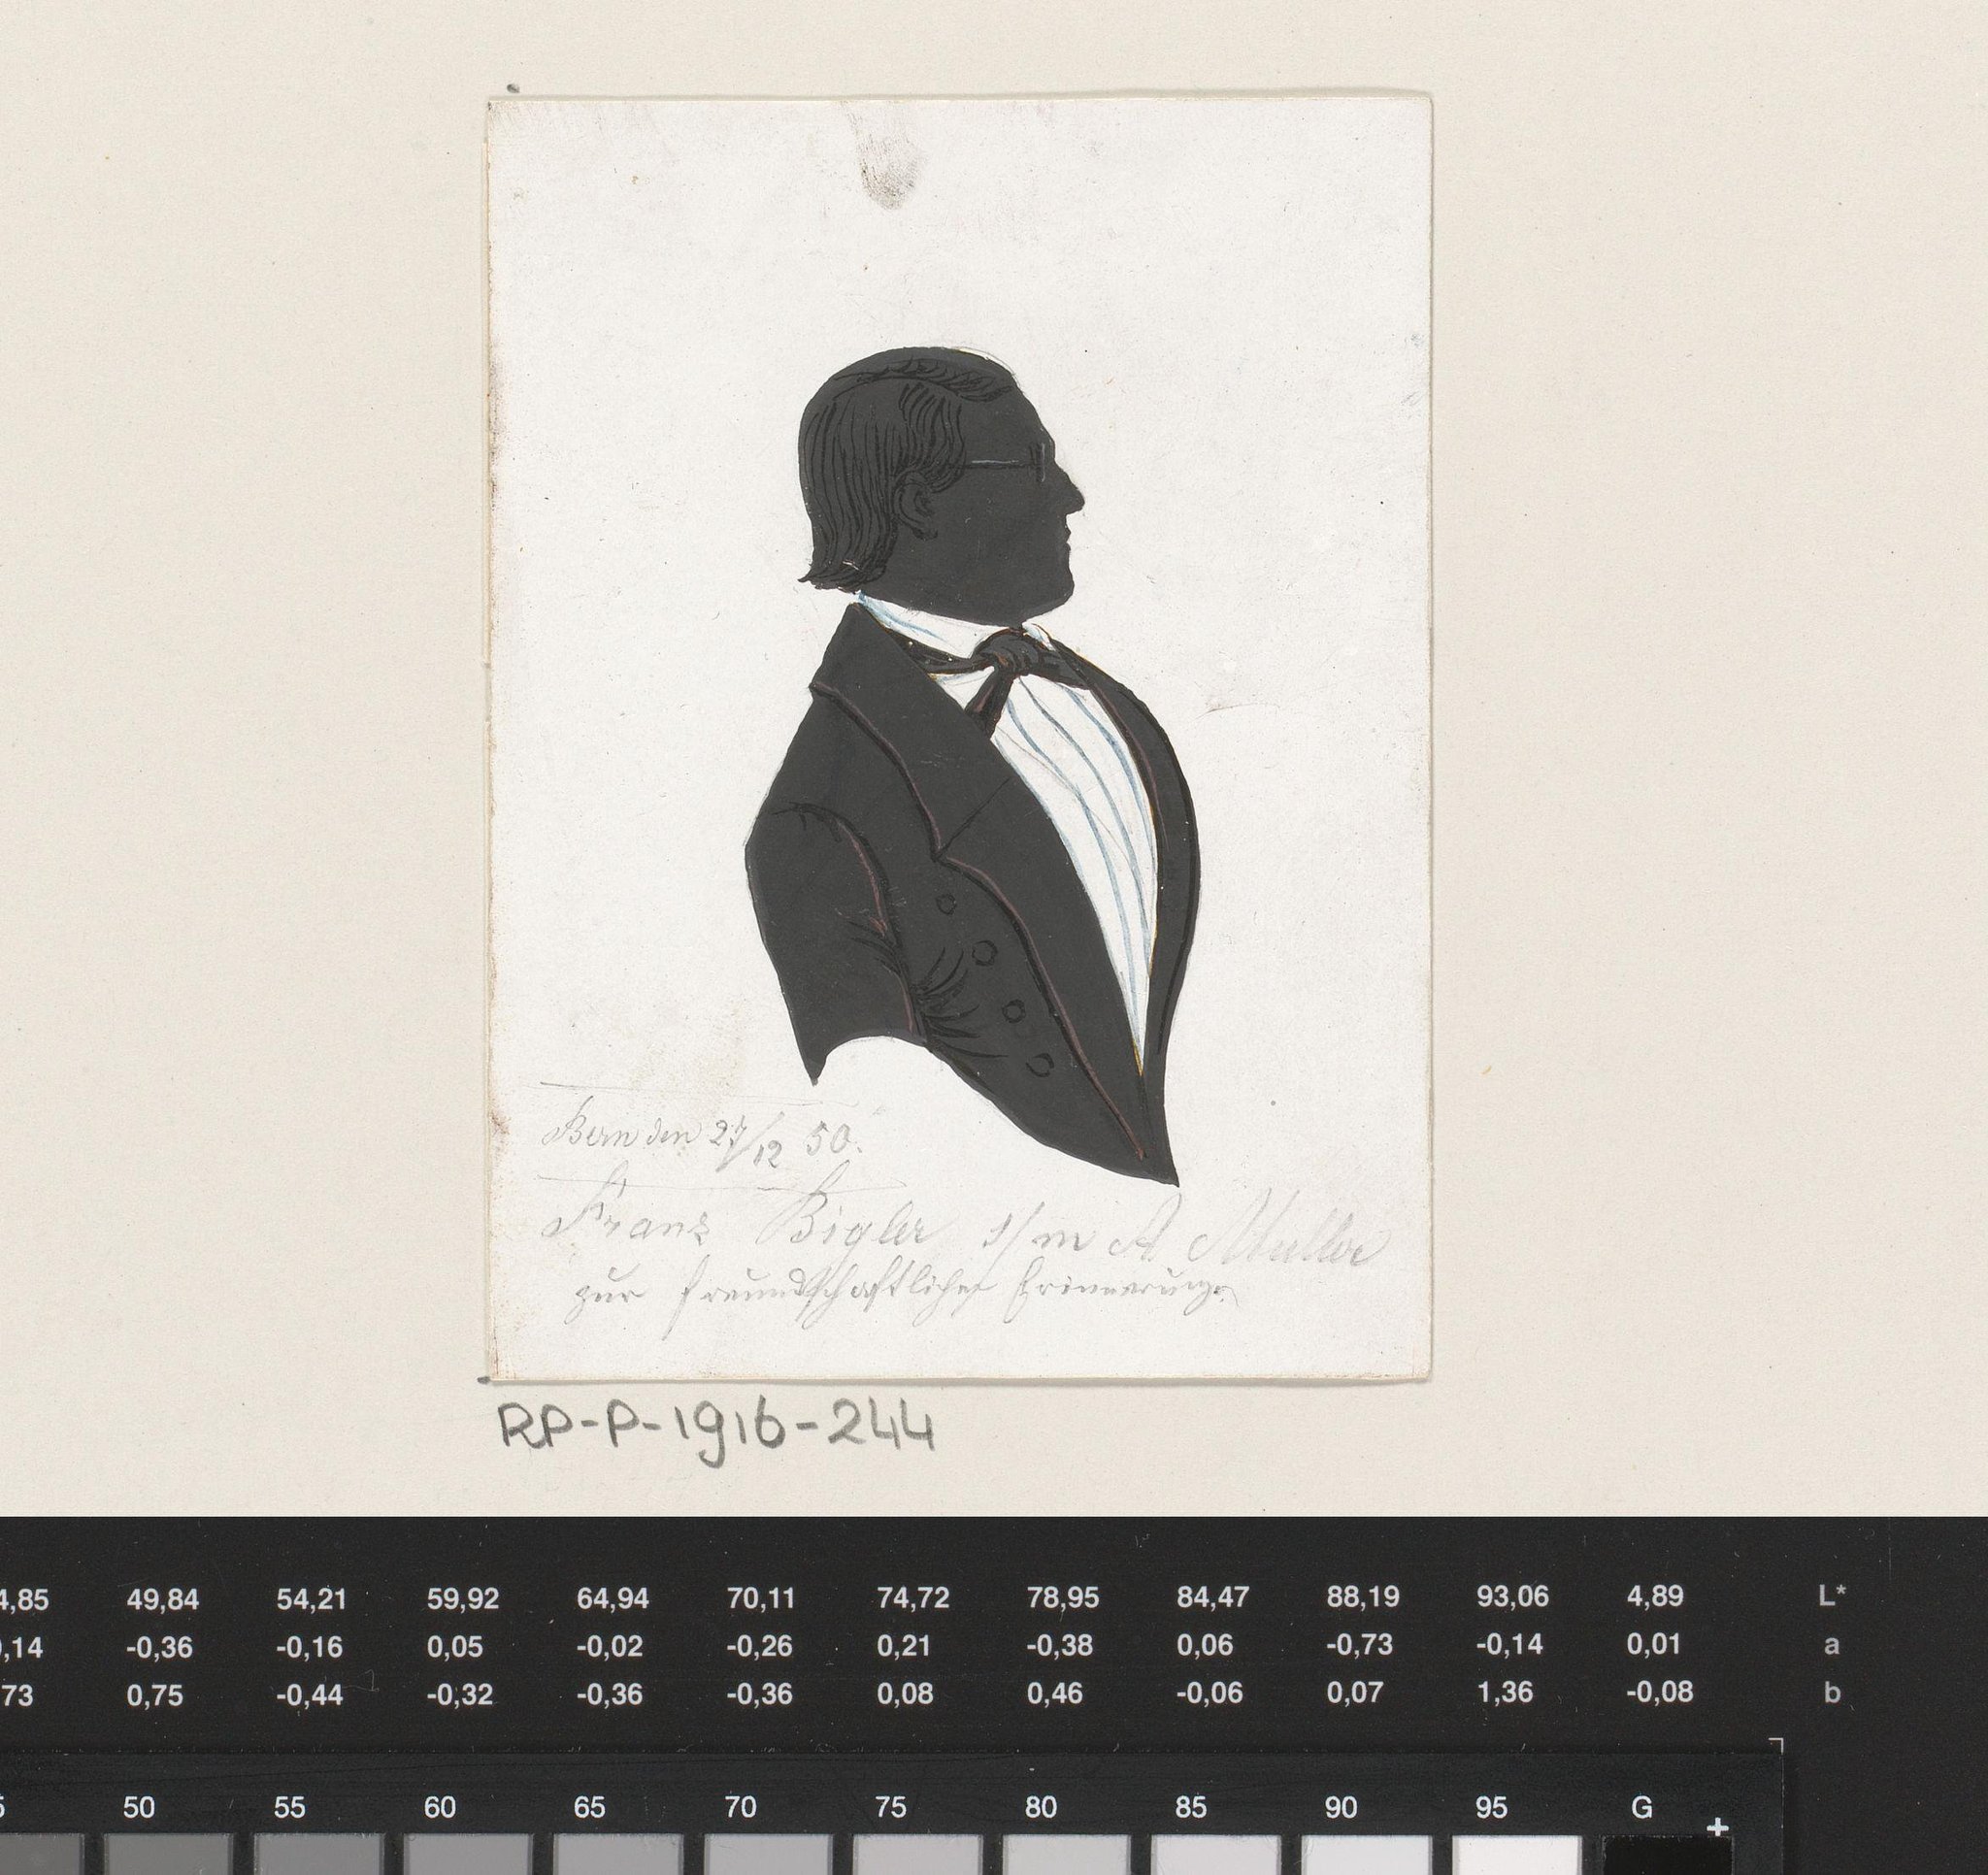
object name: drawing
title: Silhouetportret van Franz Bigler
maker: Anonymous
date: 1850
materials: ink, paint, paper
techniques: brush, pen, writing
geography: bern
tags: politician, historical persons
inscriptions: inscription: ‘Bern den 27/12 50/ Franz Bigler s/m (?) A. Muller/ zur freundschaftlicher Erinnerung’